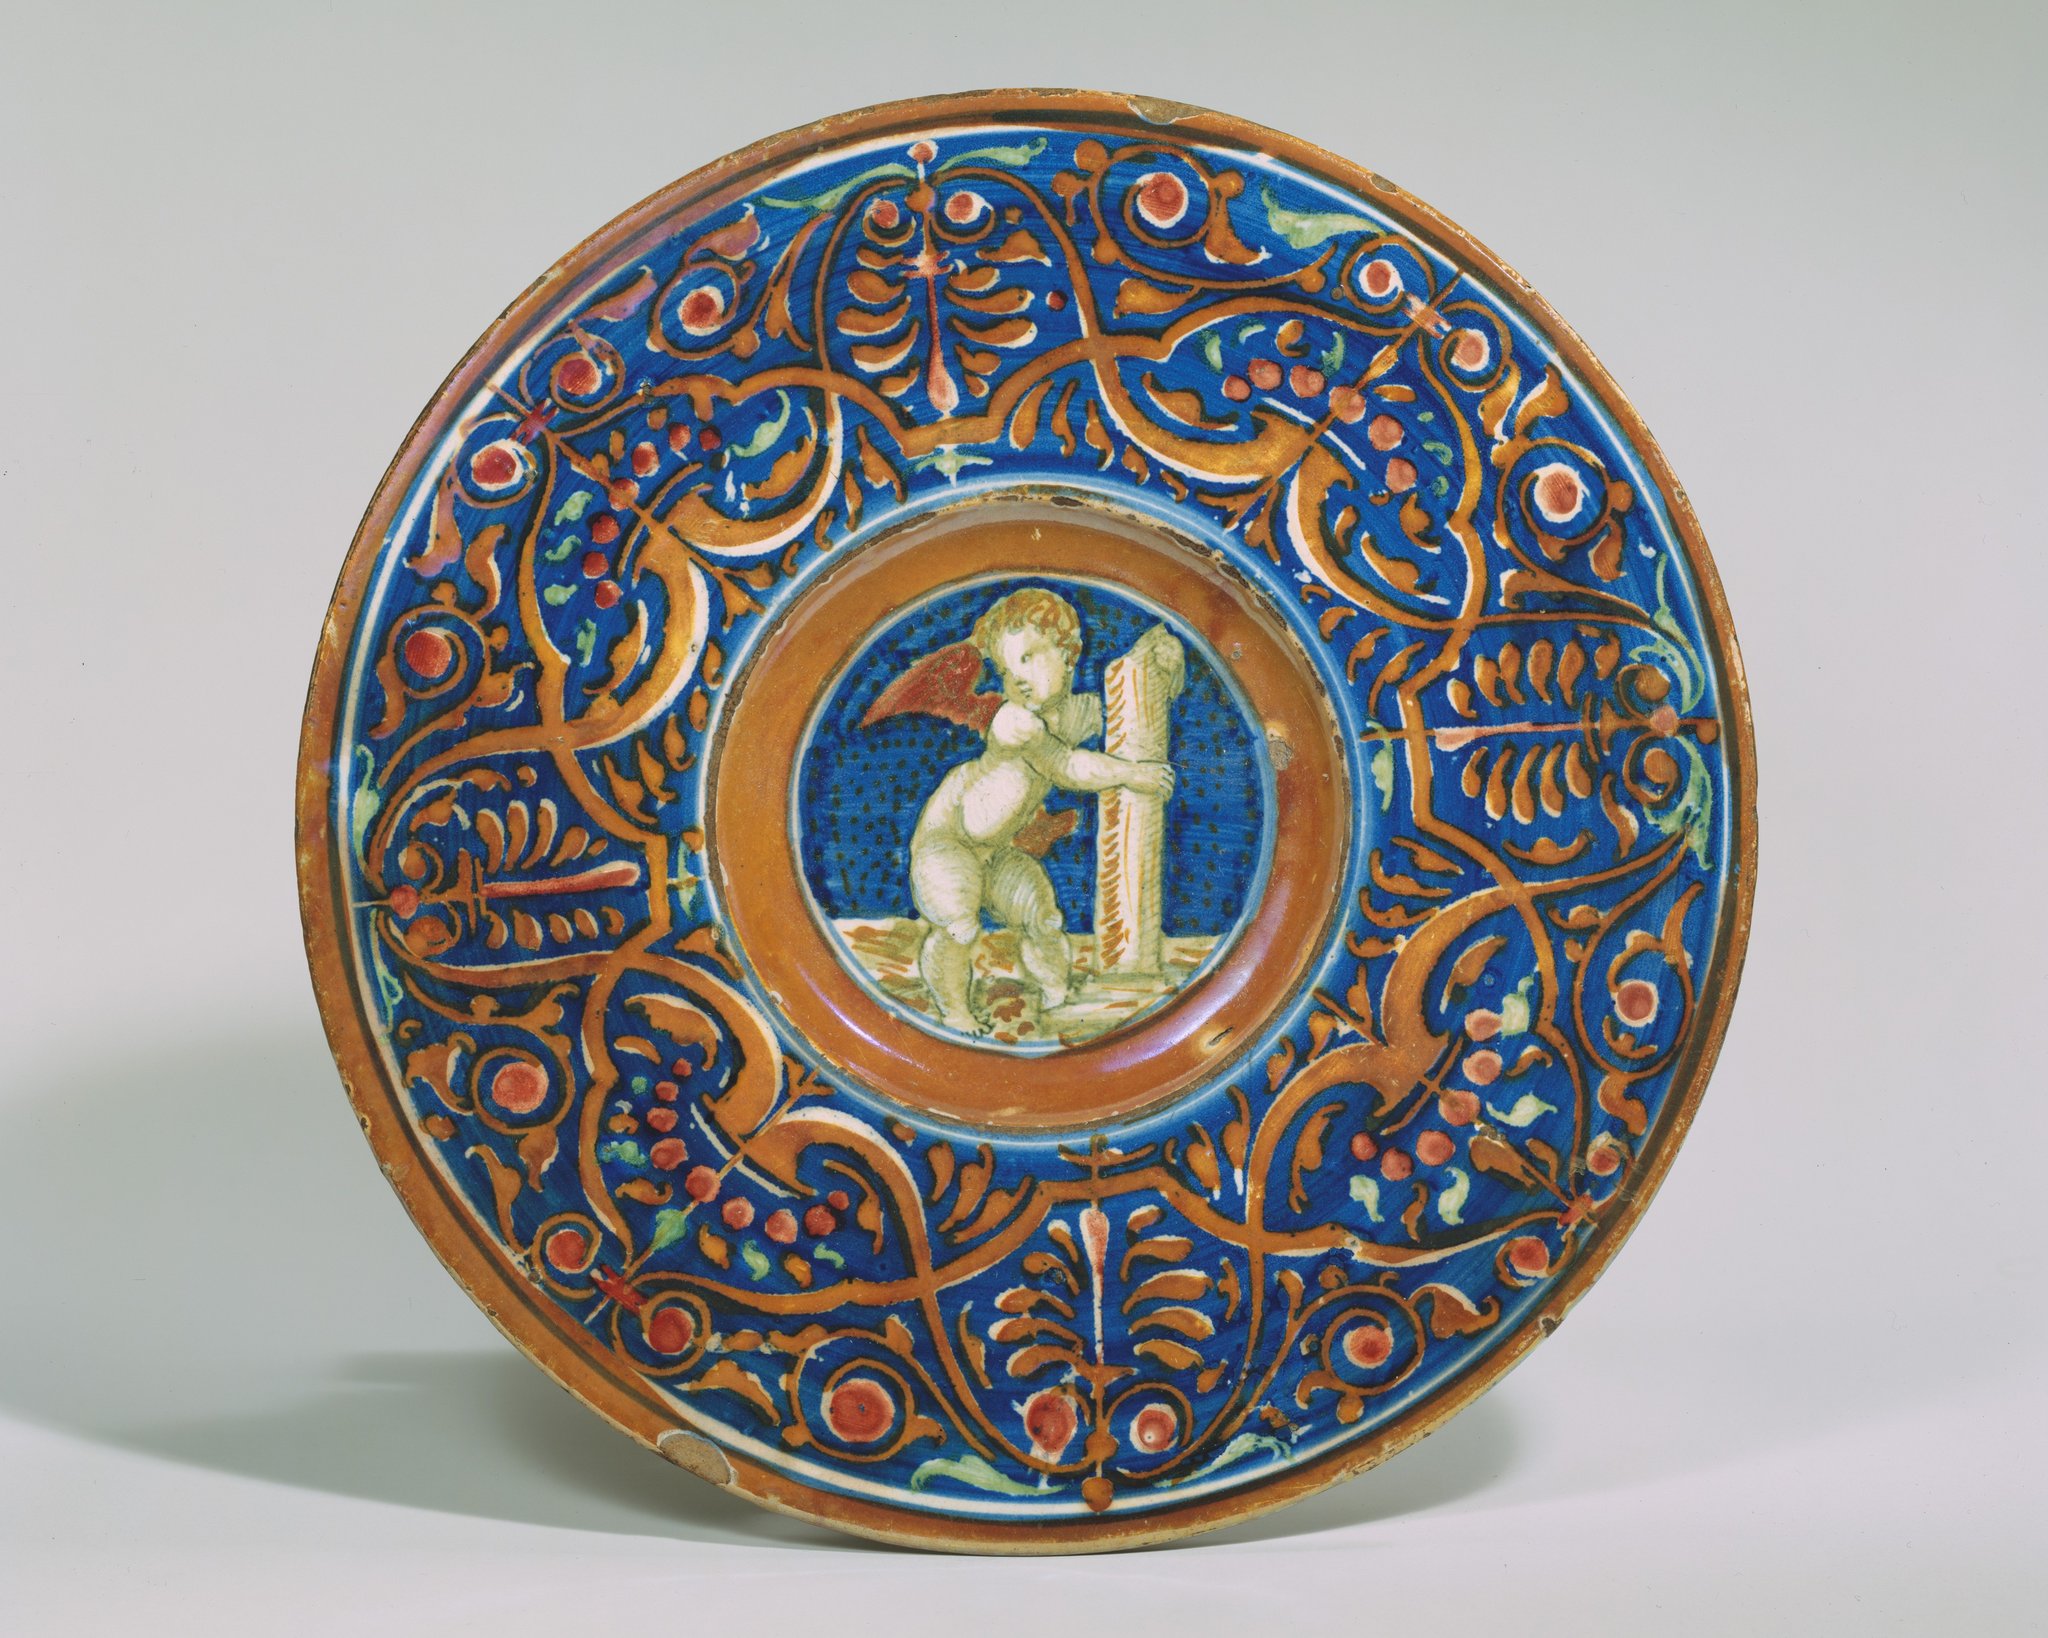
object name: plate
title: Plate (tagliere)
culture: italian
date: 1525-1530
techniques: maiolica, glazing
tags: putti